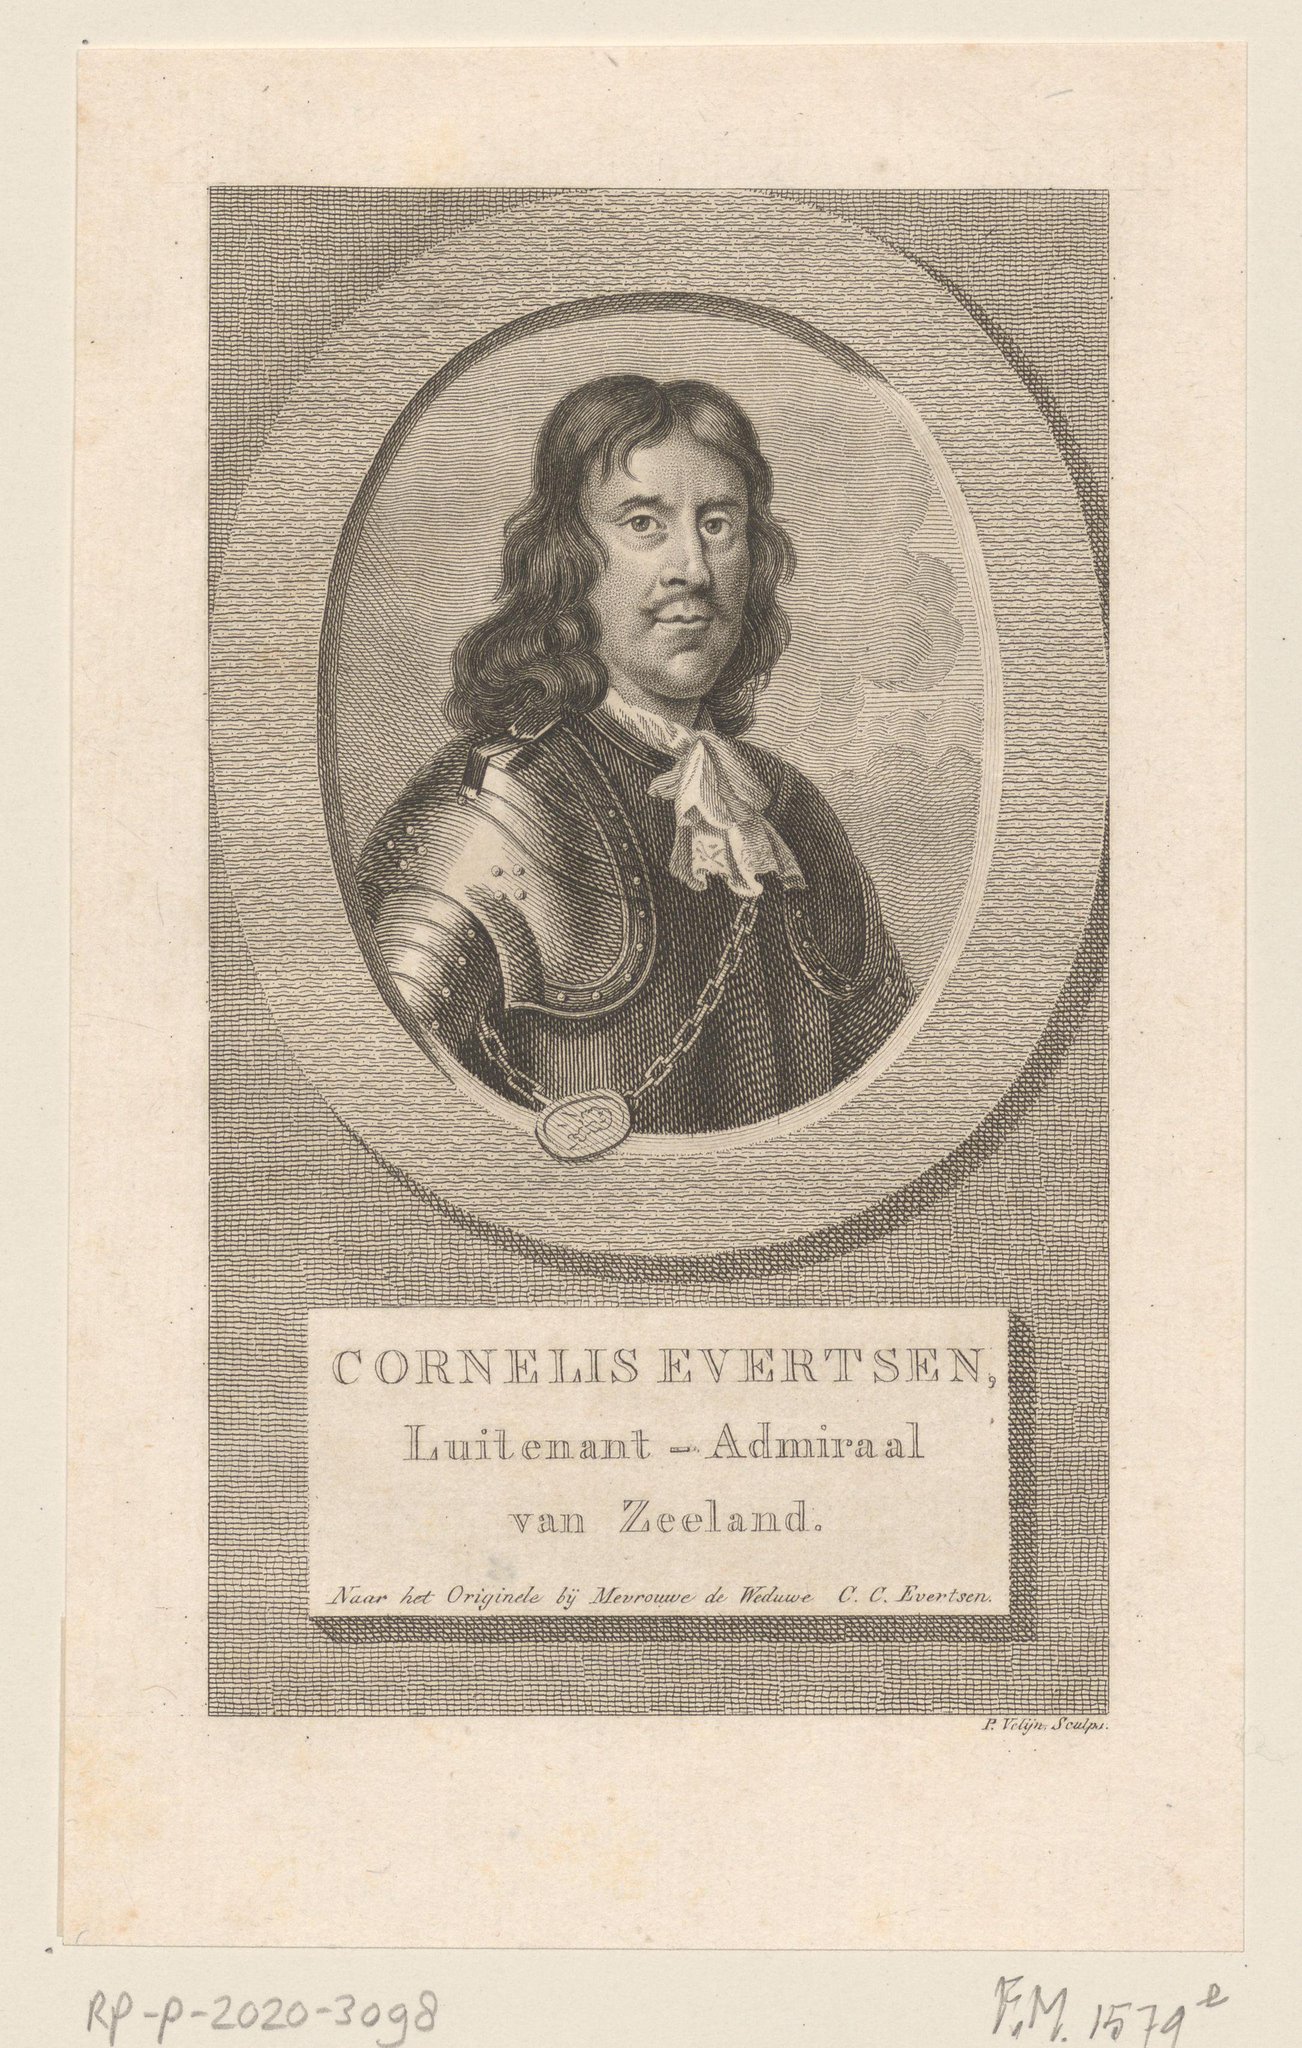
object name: print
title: Portret van Cornelis Evertsen (I)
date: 1797-1836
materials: paper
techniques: etching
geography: netherlands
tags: historical persons